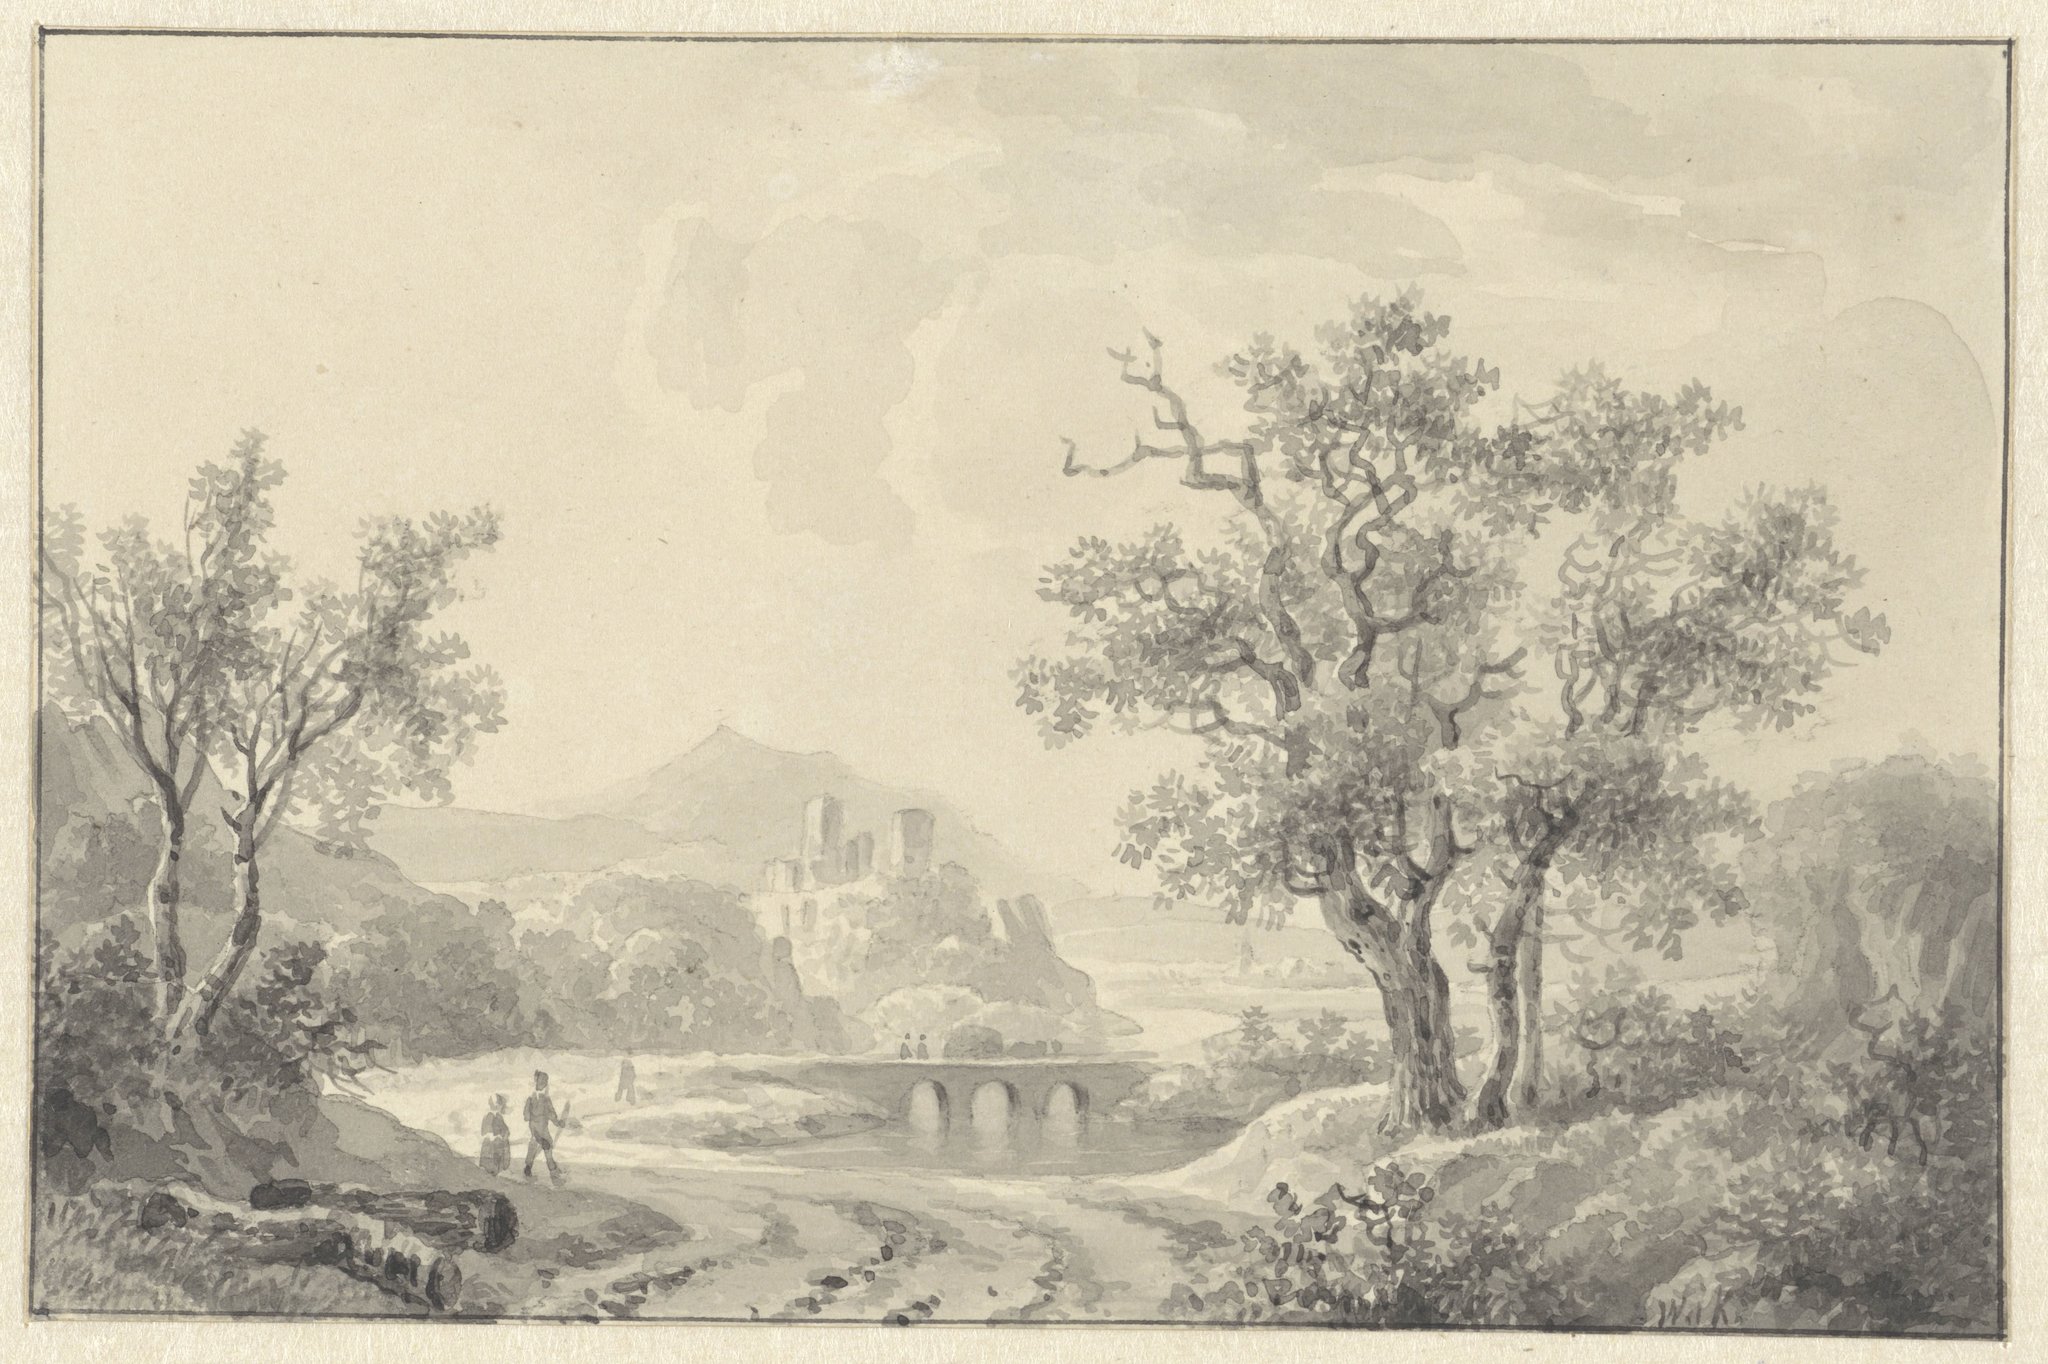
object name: drawing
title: Landschap met ruïne in het verschiet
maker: willem de klerk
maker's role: draughtsman, painter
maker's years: 1800-1876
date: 1810-1876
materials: paper, pencil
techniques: brush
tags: river, landscape with ruins